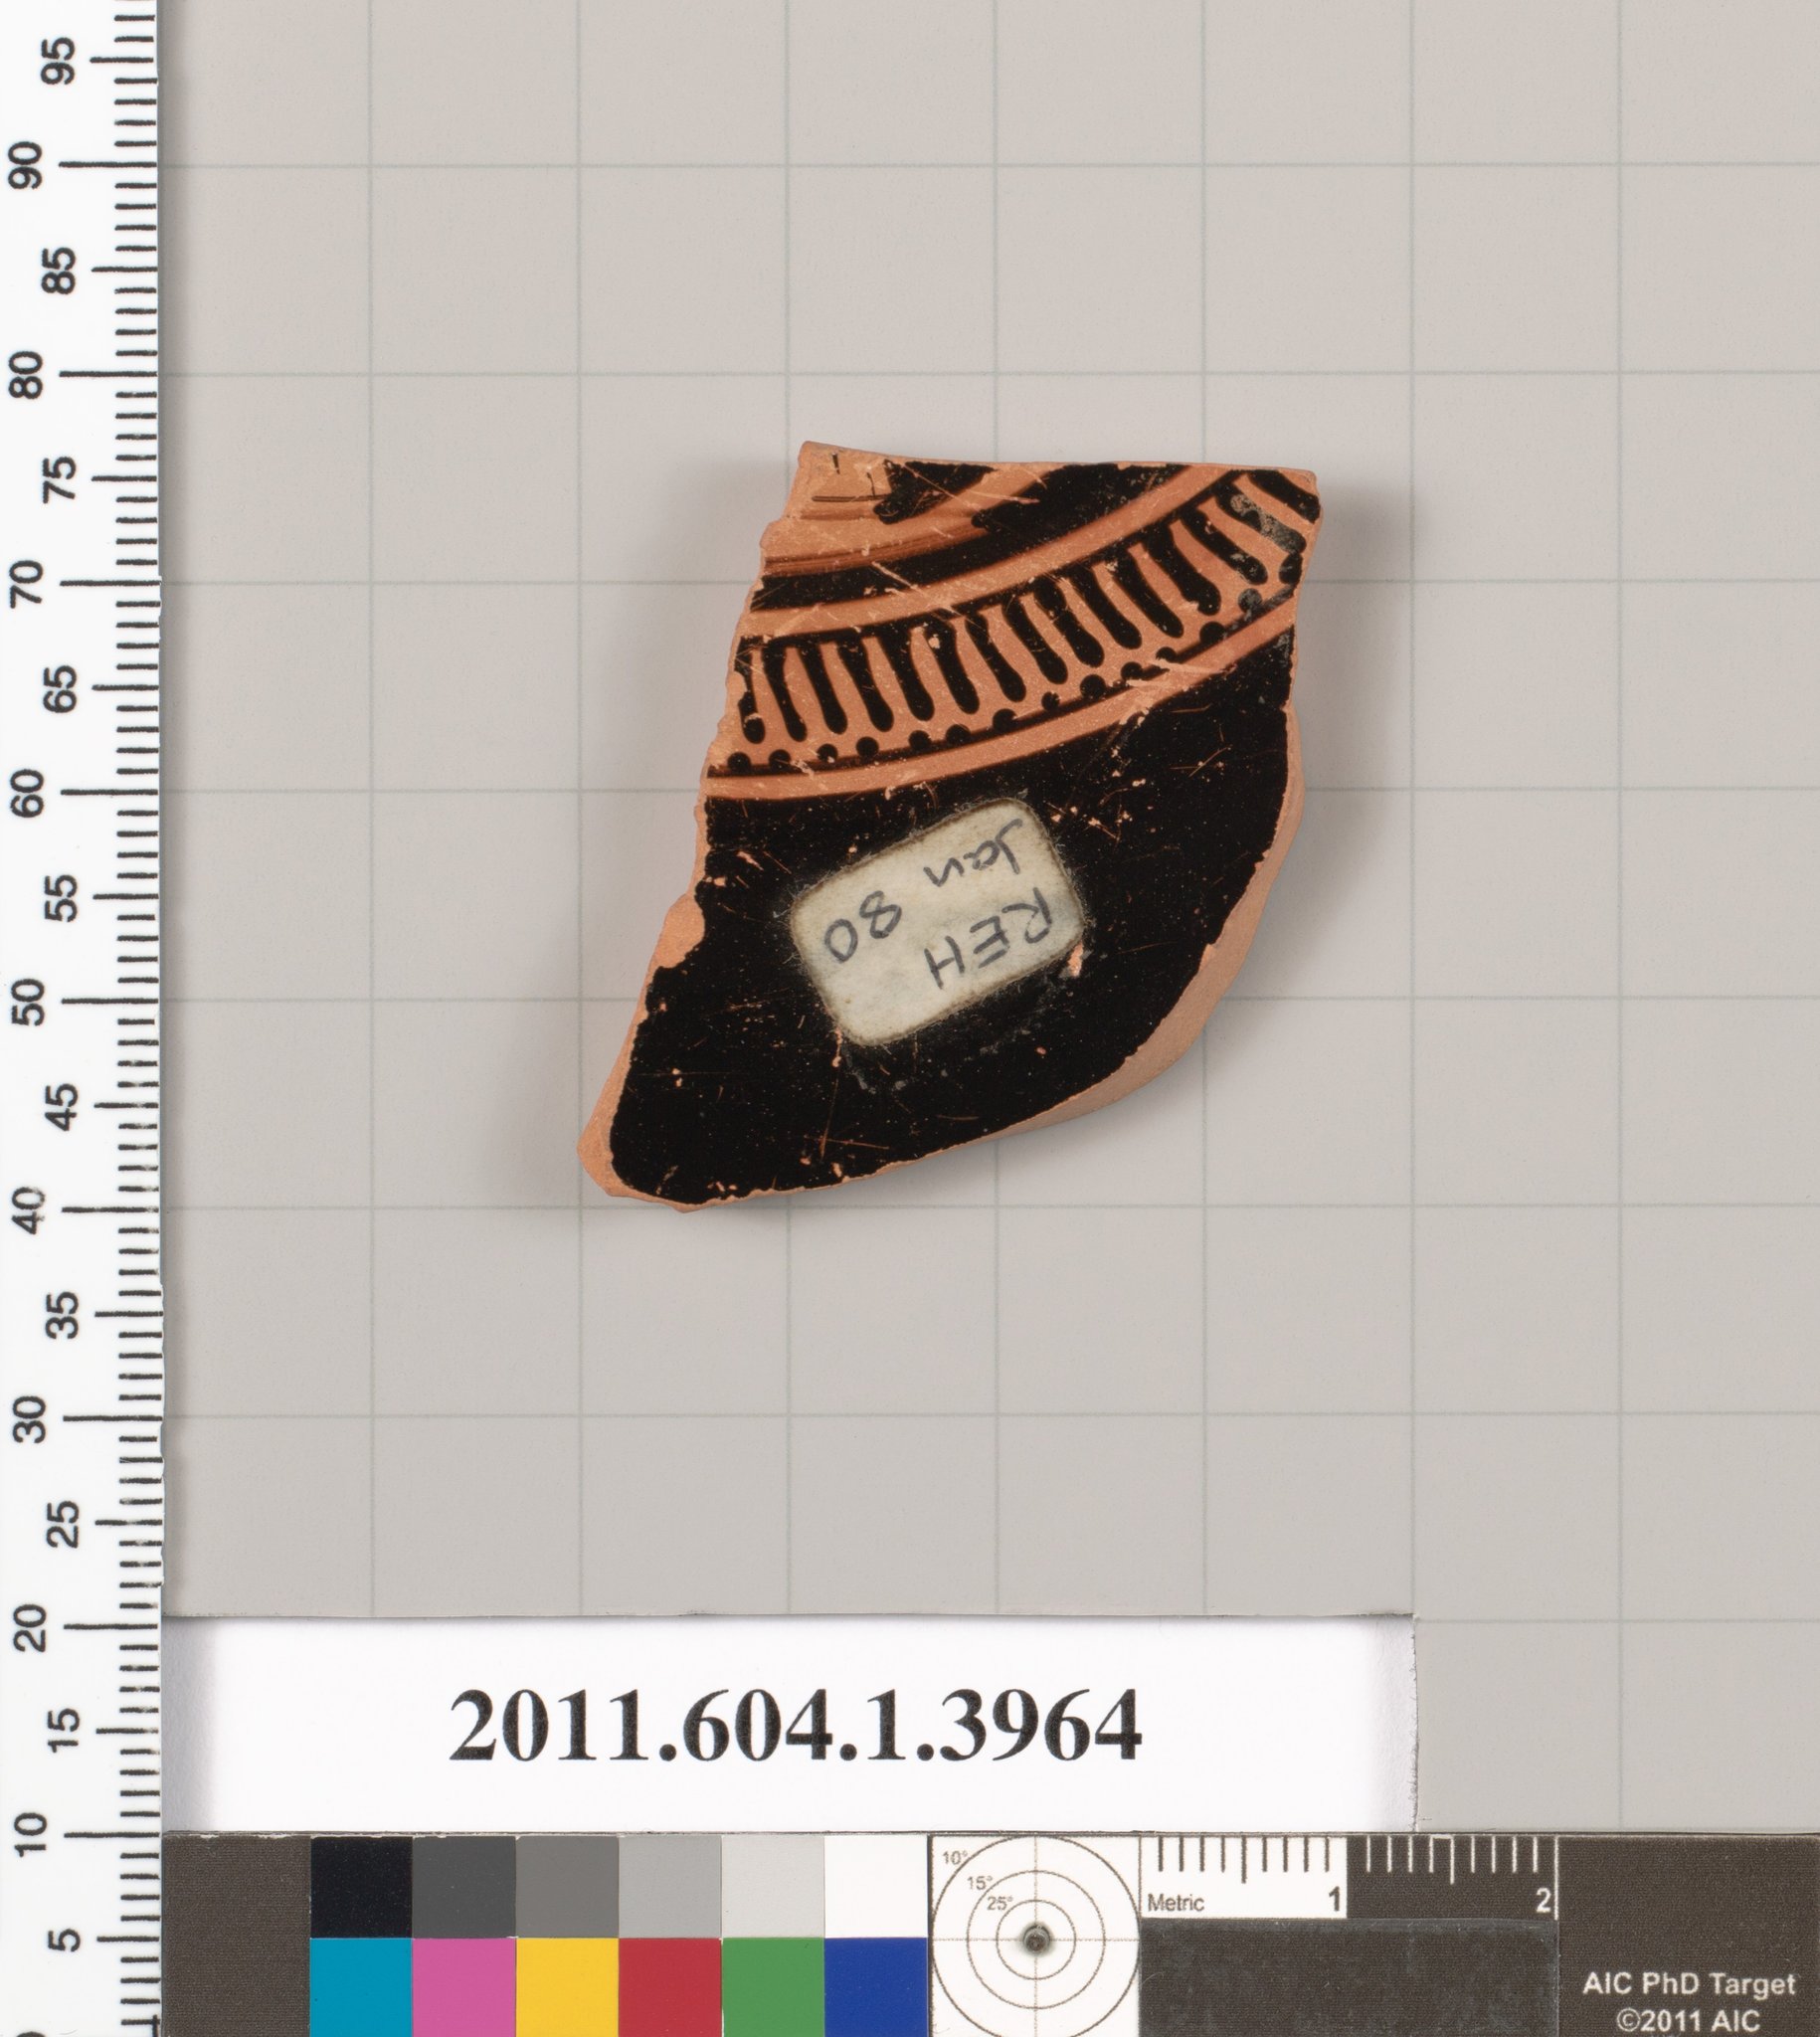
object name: kylix fragment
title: Terracotta fragment of a kylix (drinking cup)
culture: greek, attic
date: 475-451 BCE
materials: terracotta